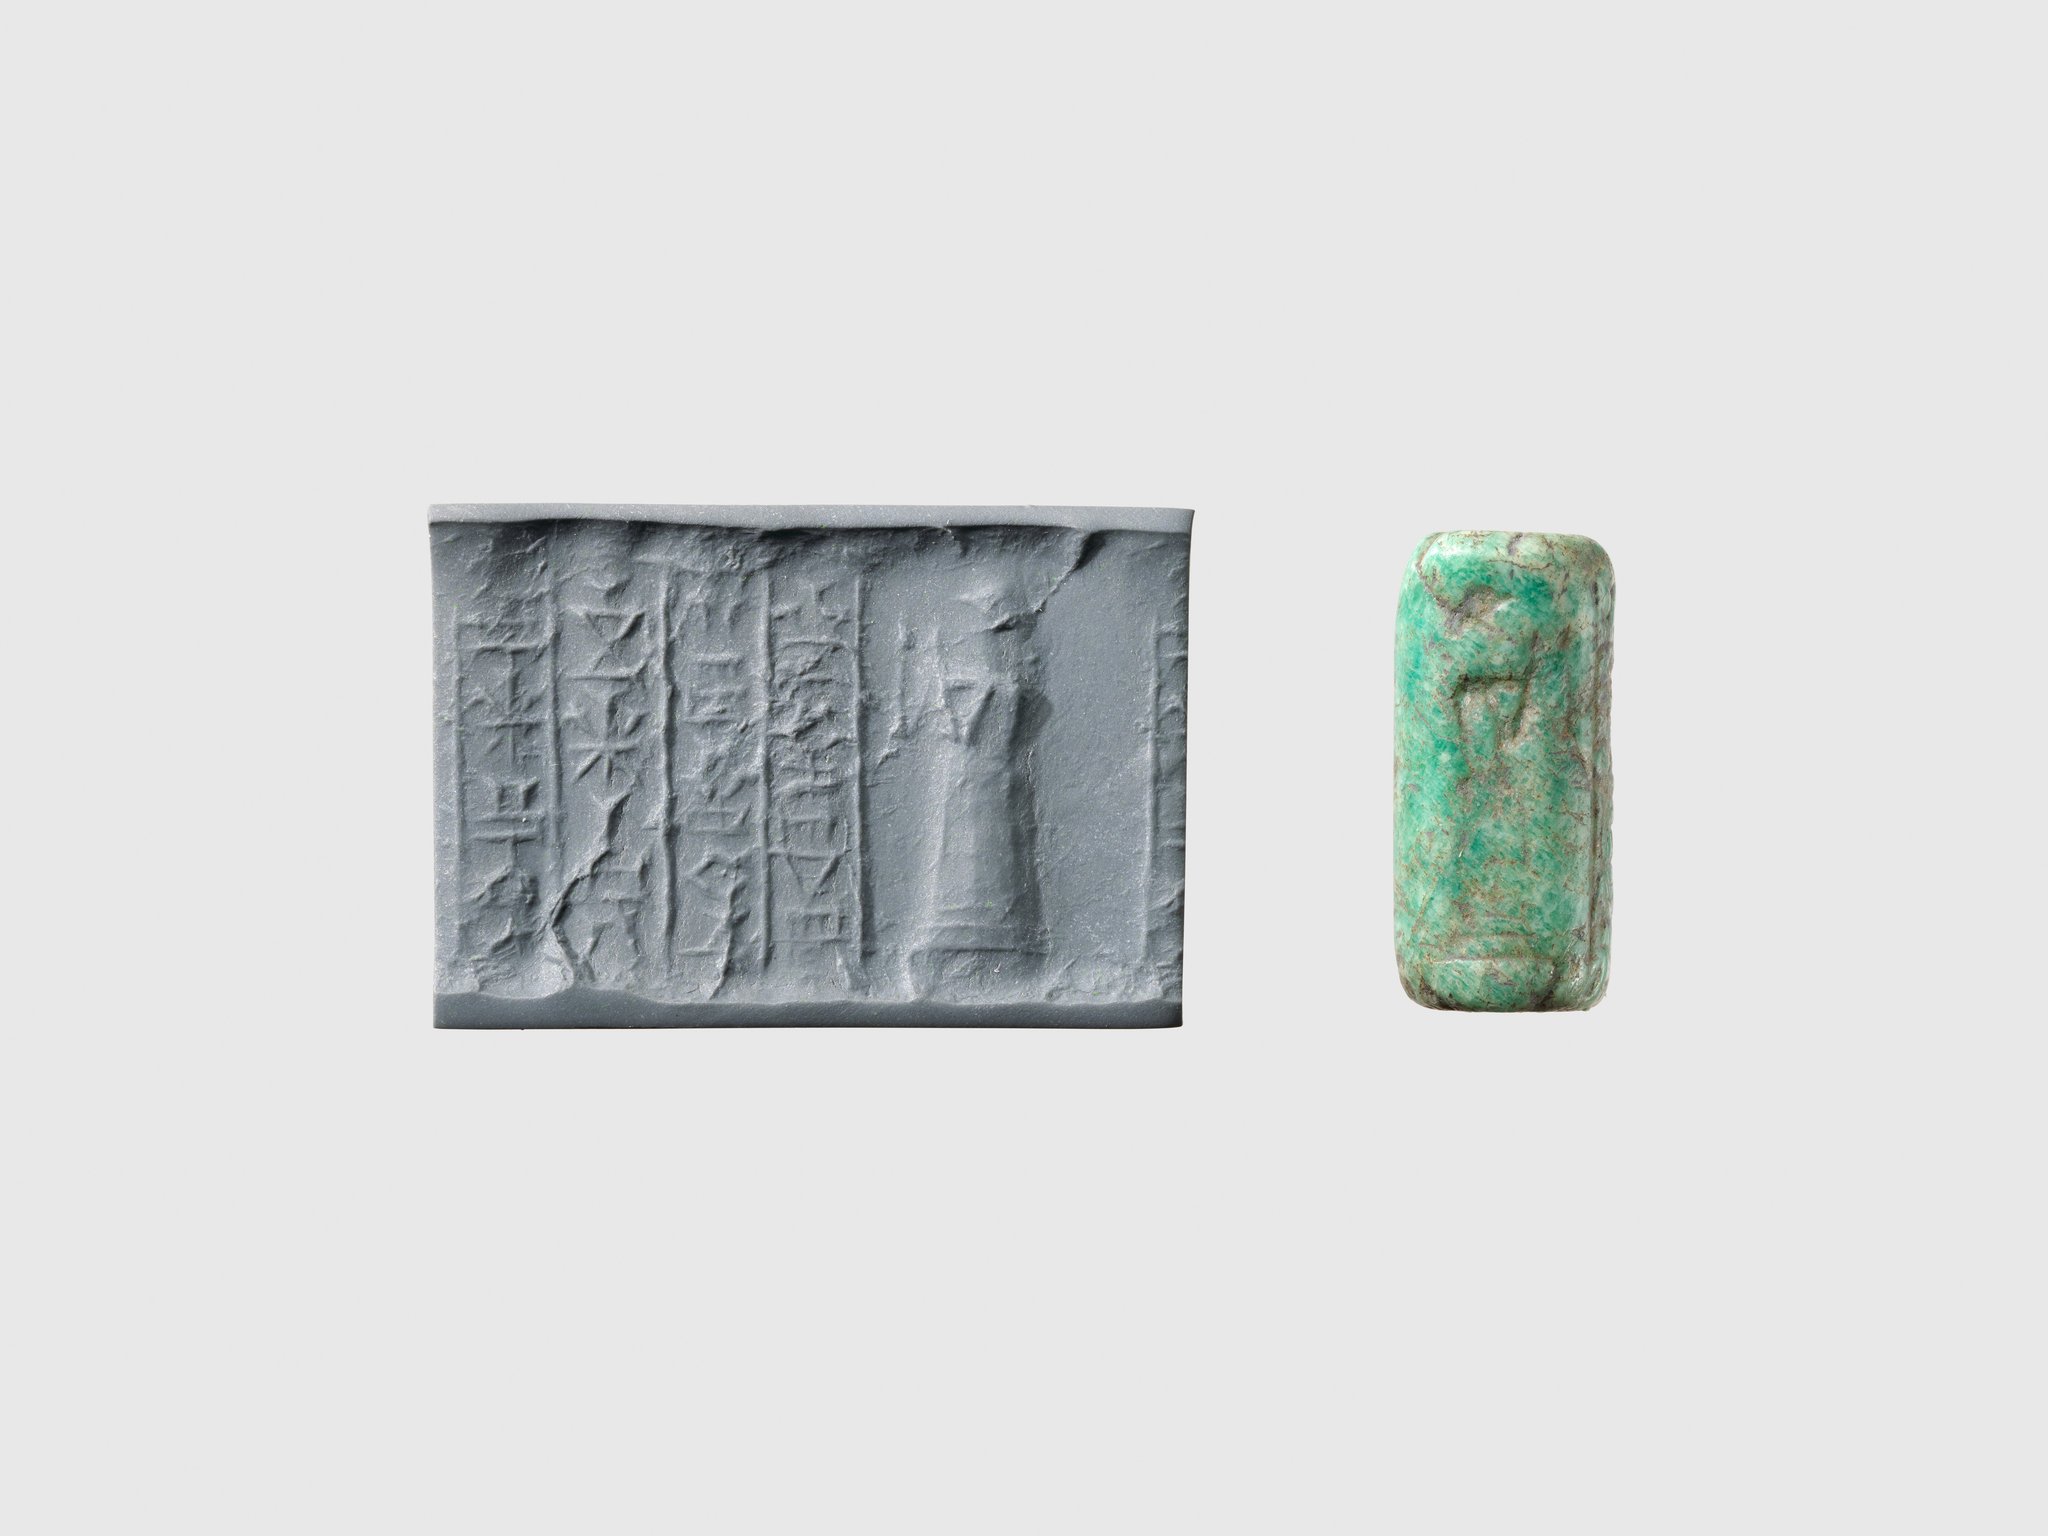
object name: cylinder seal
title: Cylinder seal and modern impression: suppliant goddess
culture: babylonian or kassite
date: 1700-1501 BCE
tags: goddess